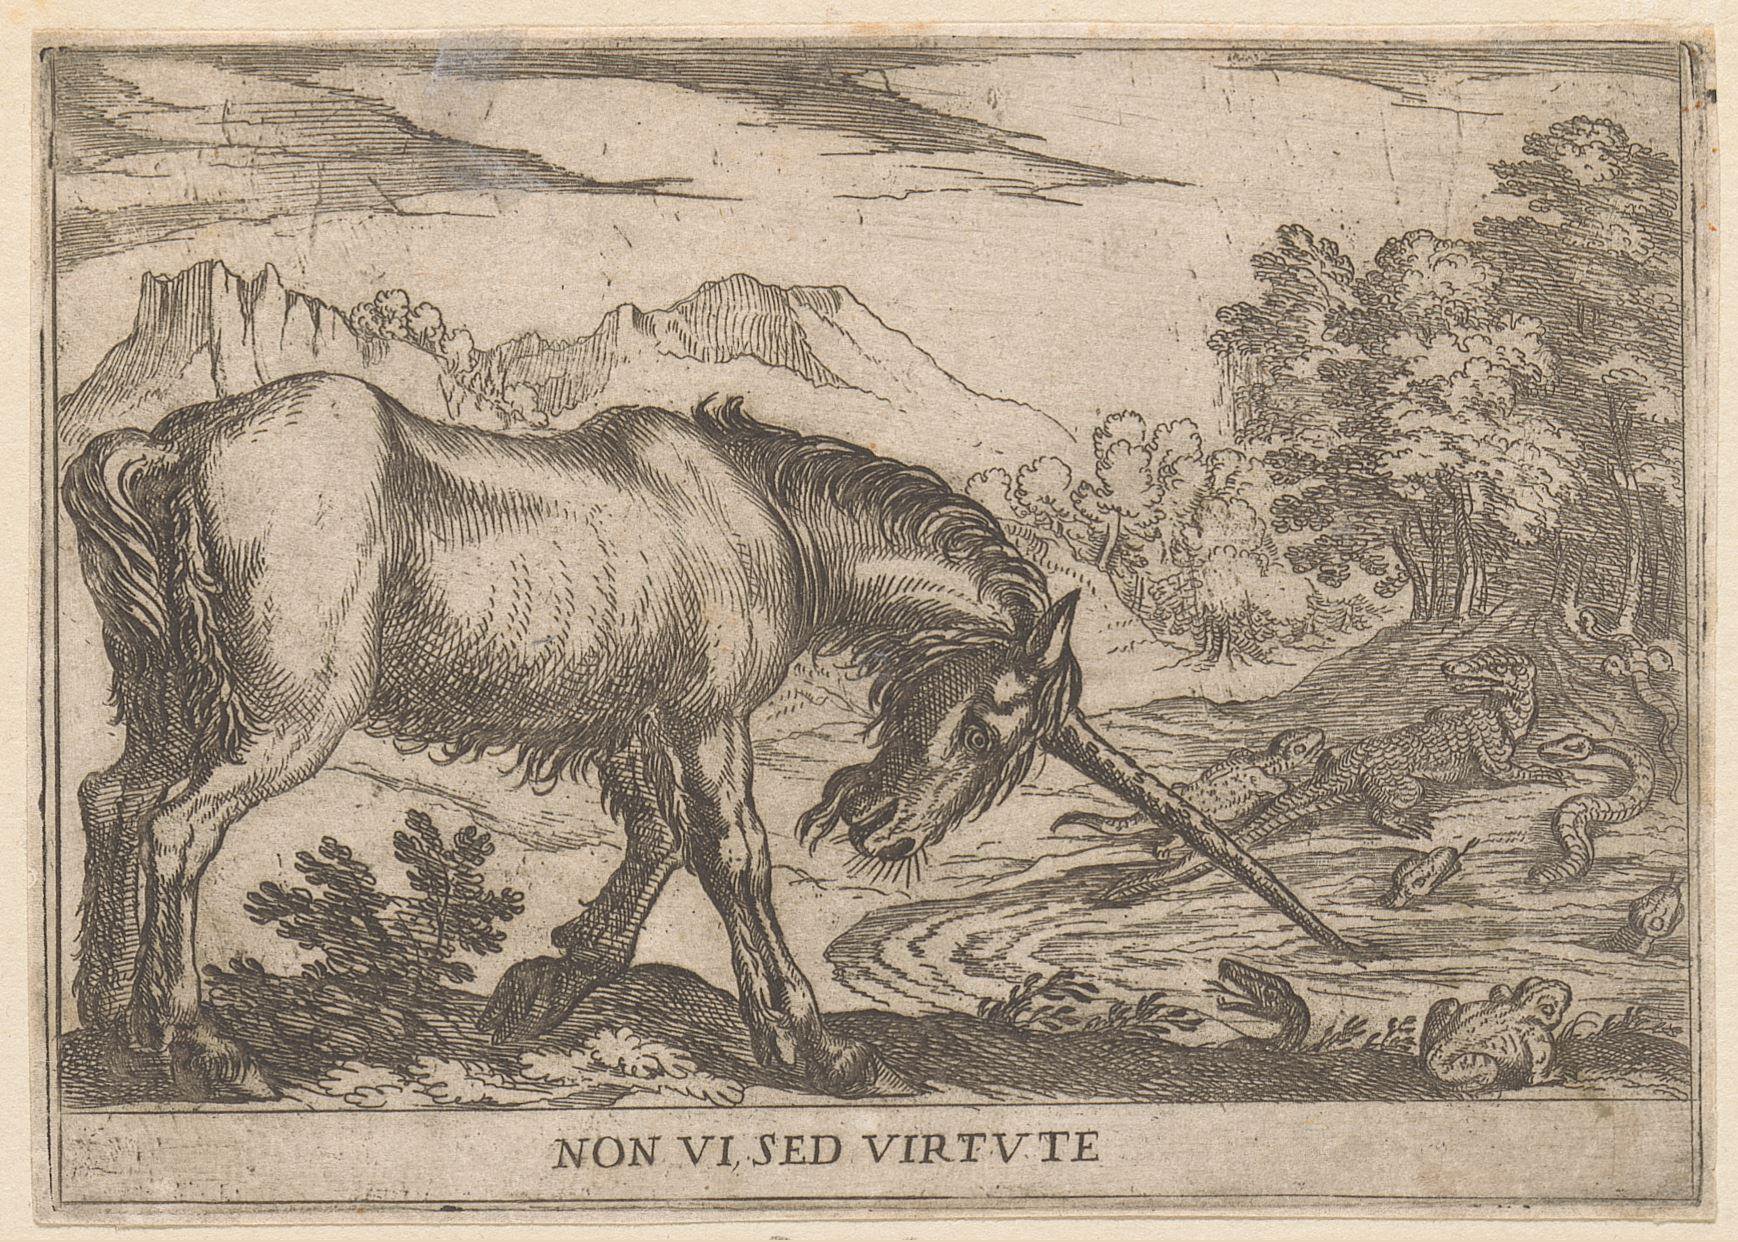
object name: print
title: Een eenhoorn verjaagt hagedissen uit een vijver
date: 1600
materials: paper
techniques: etching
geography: italy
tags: unicorn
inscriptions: collector's mark: Lugt 240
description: Deze prent maakt deel uit van een reeks van 25 prenten (+ titelprent) van vechtende dieren.